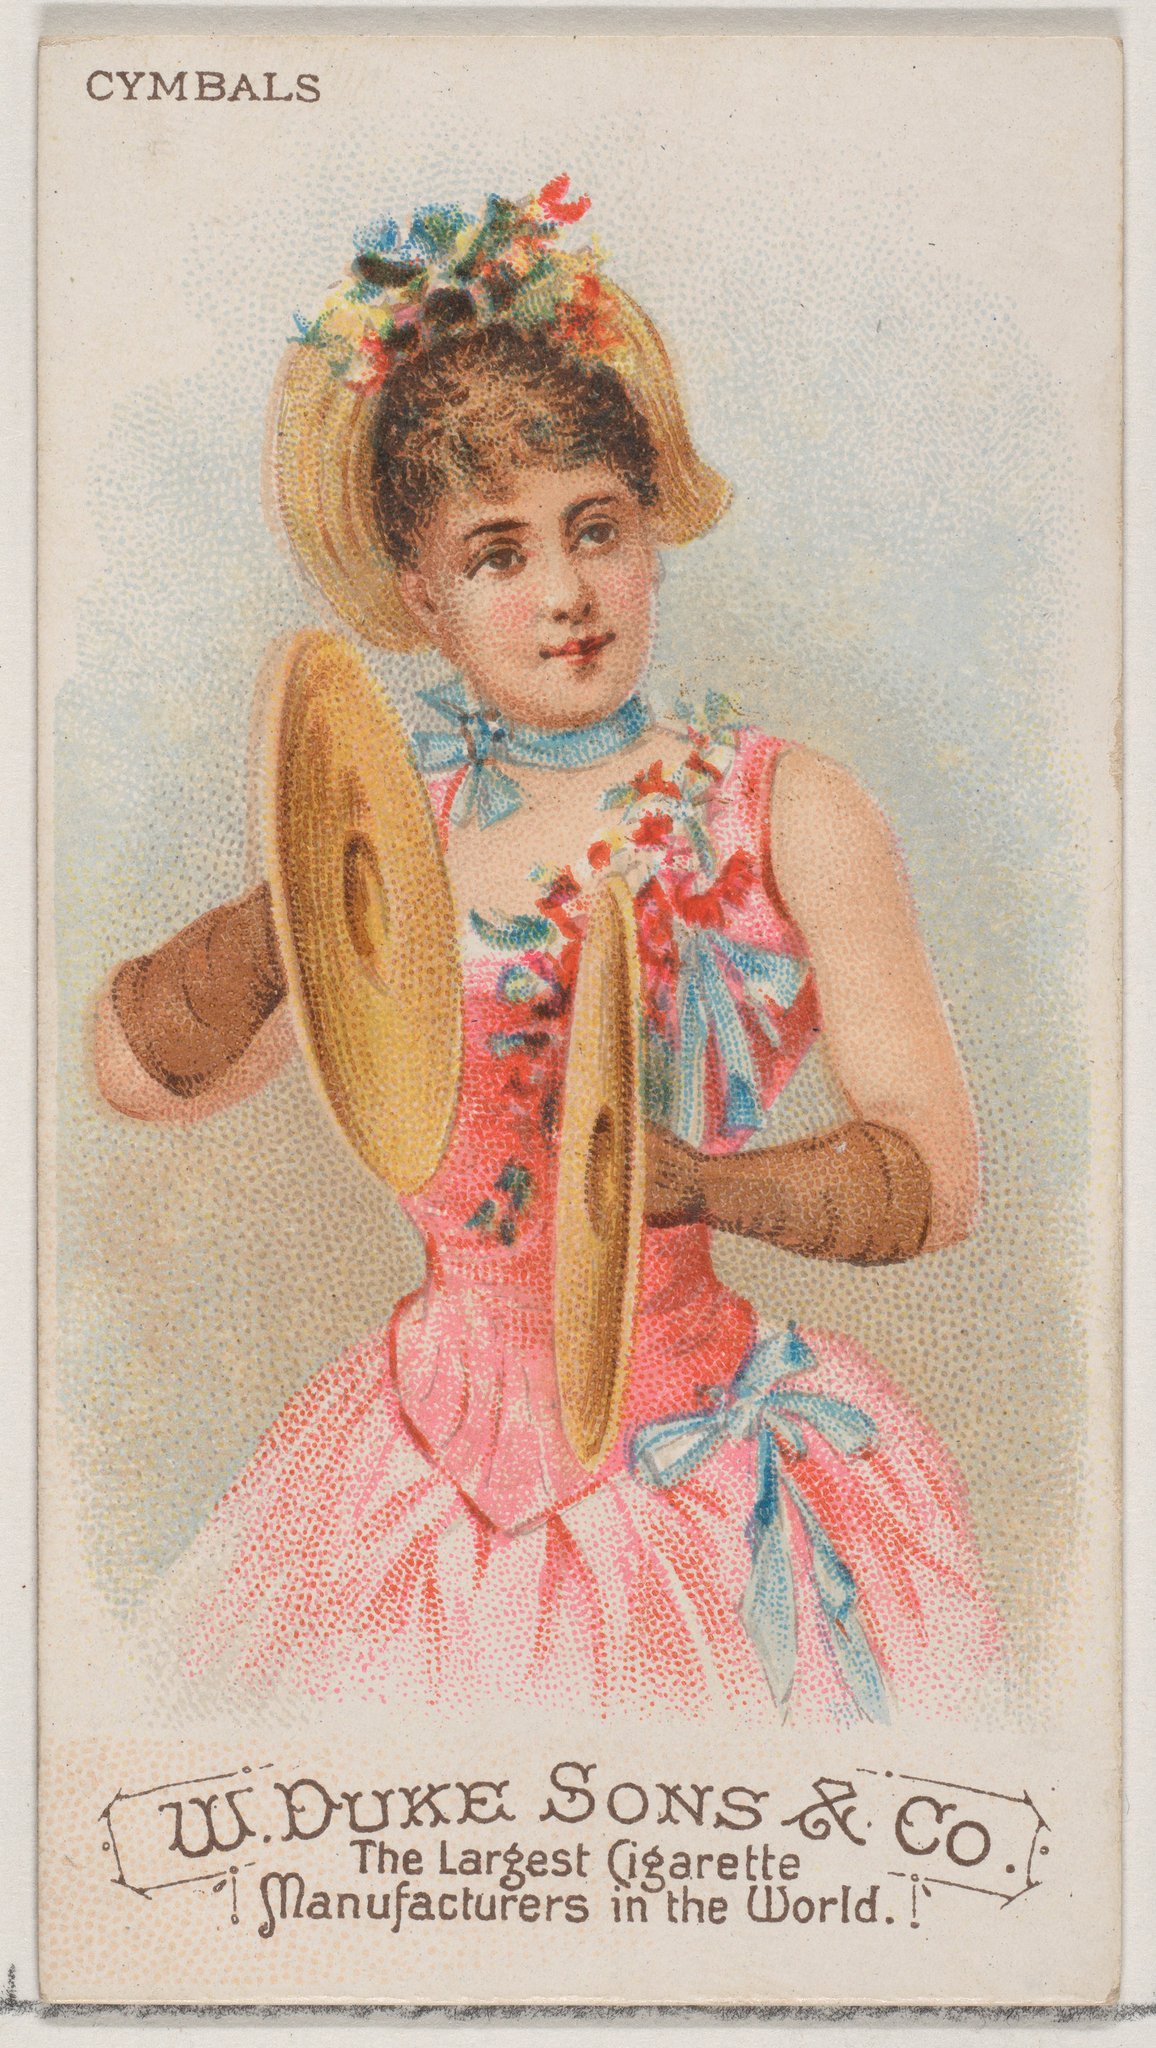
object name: print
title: Cymbals, from the Musical Instruments series (N82) for Duke brand cigarettes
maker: w. duke, sons & co.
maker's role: publisher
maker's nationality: american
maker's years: 1870-1920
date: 1888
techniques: color lithograph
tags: musical instruments,women,musicians